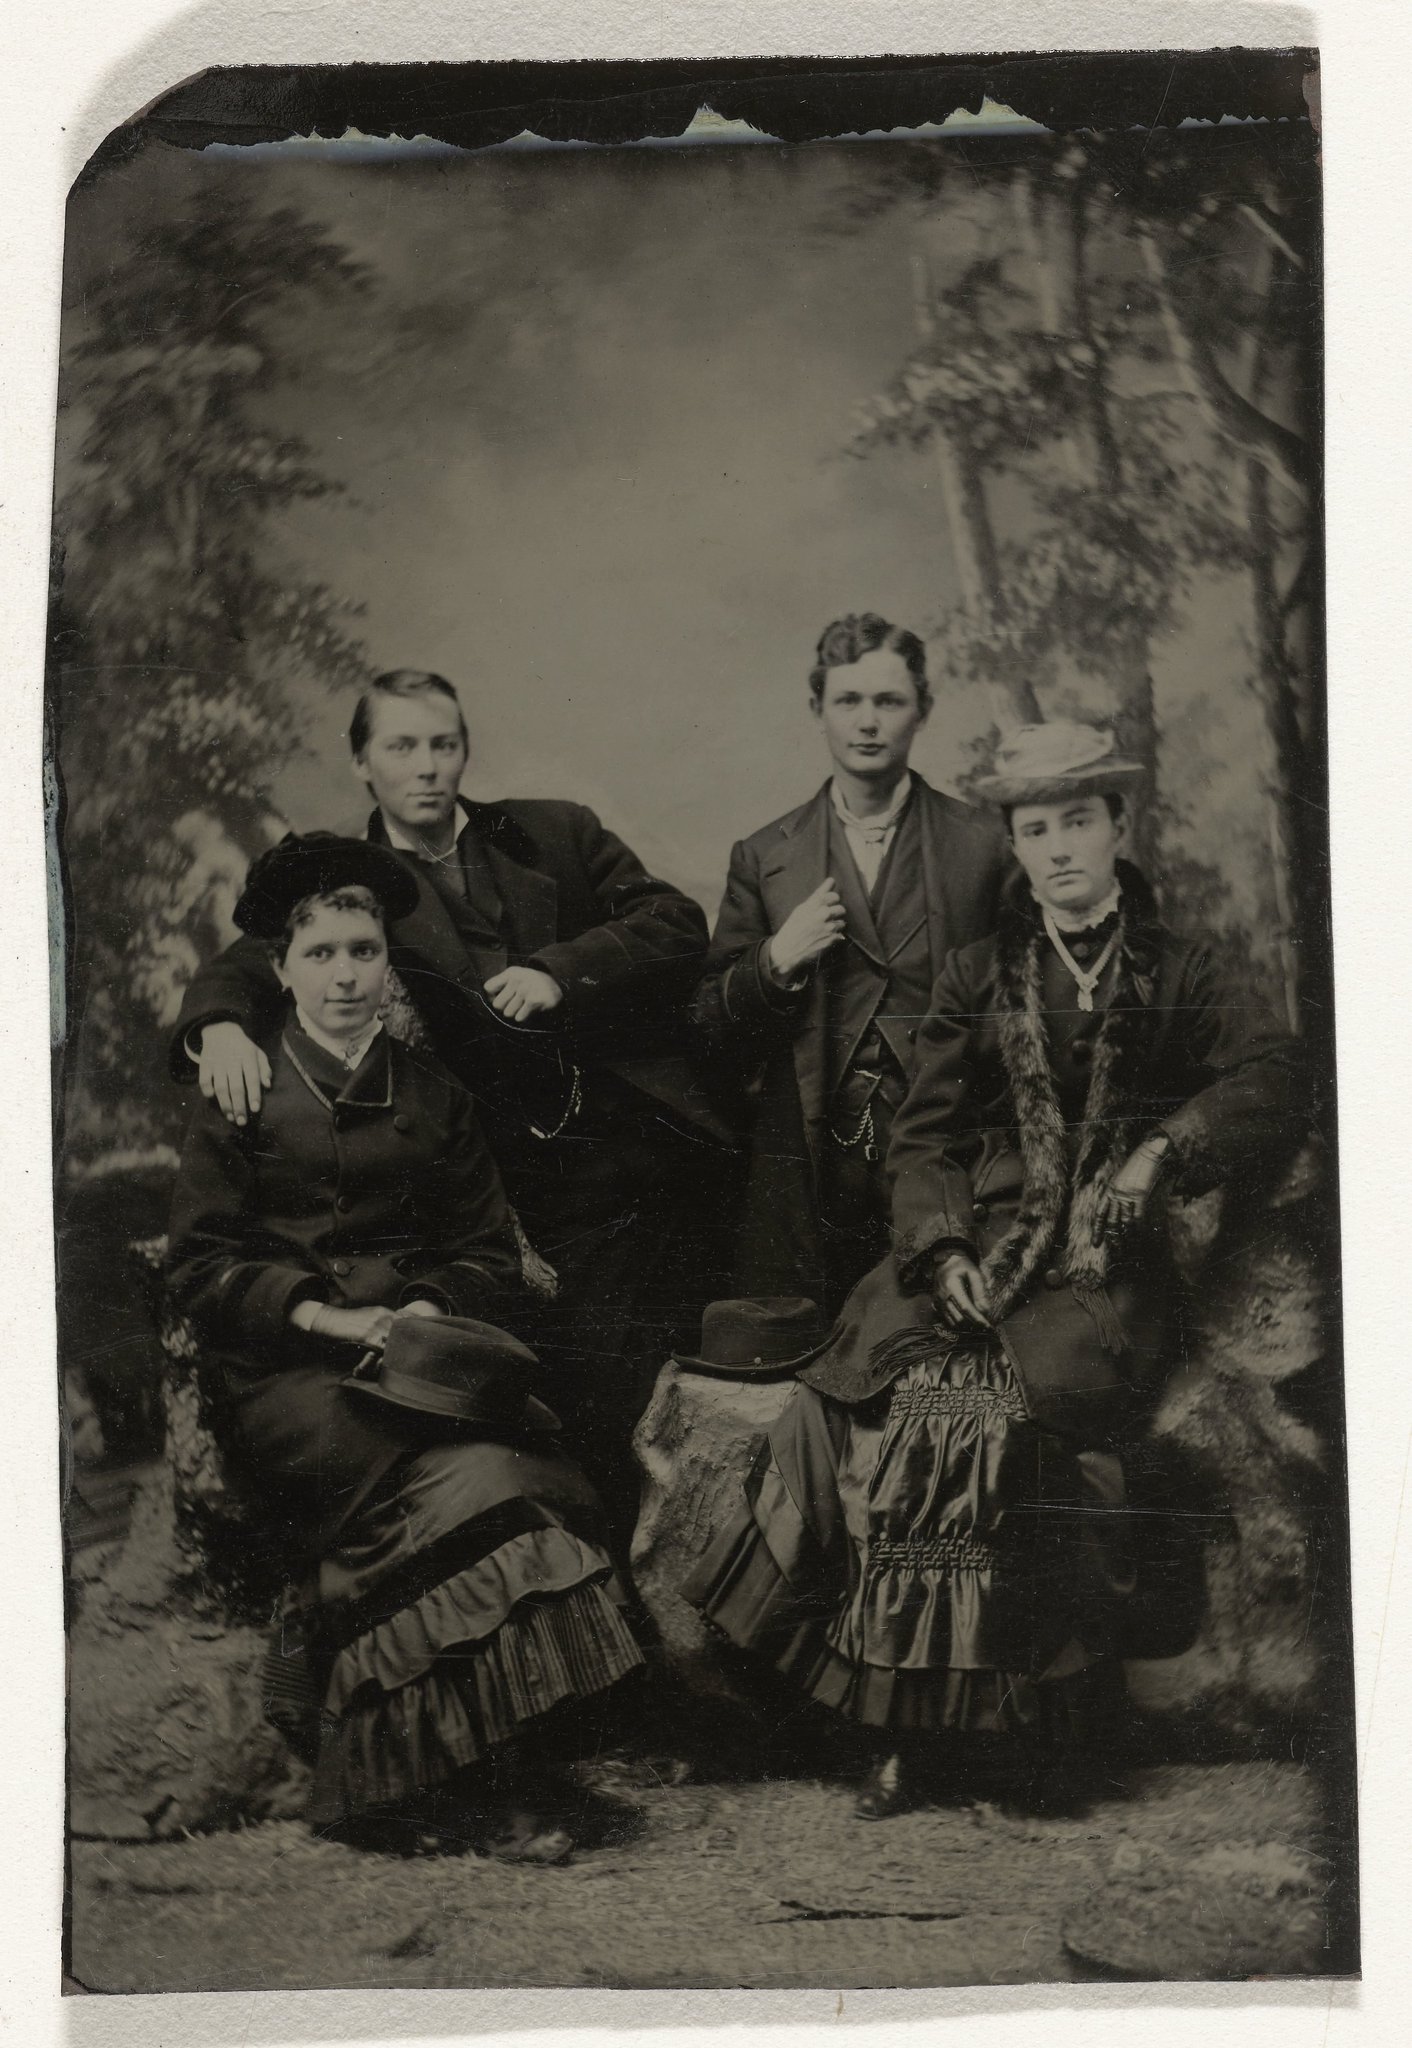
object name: photograph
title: Twee mannen en twee vrouwen, staand en zittend voor een geschilderd achtergronddoek (bos)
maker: Anonymous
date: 1870-1900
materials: metal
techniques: ferrotyping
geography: united states